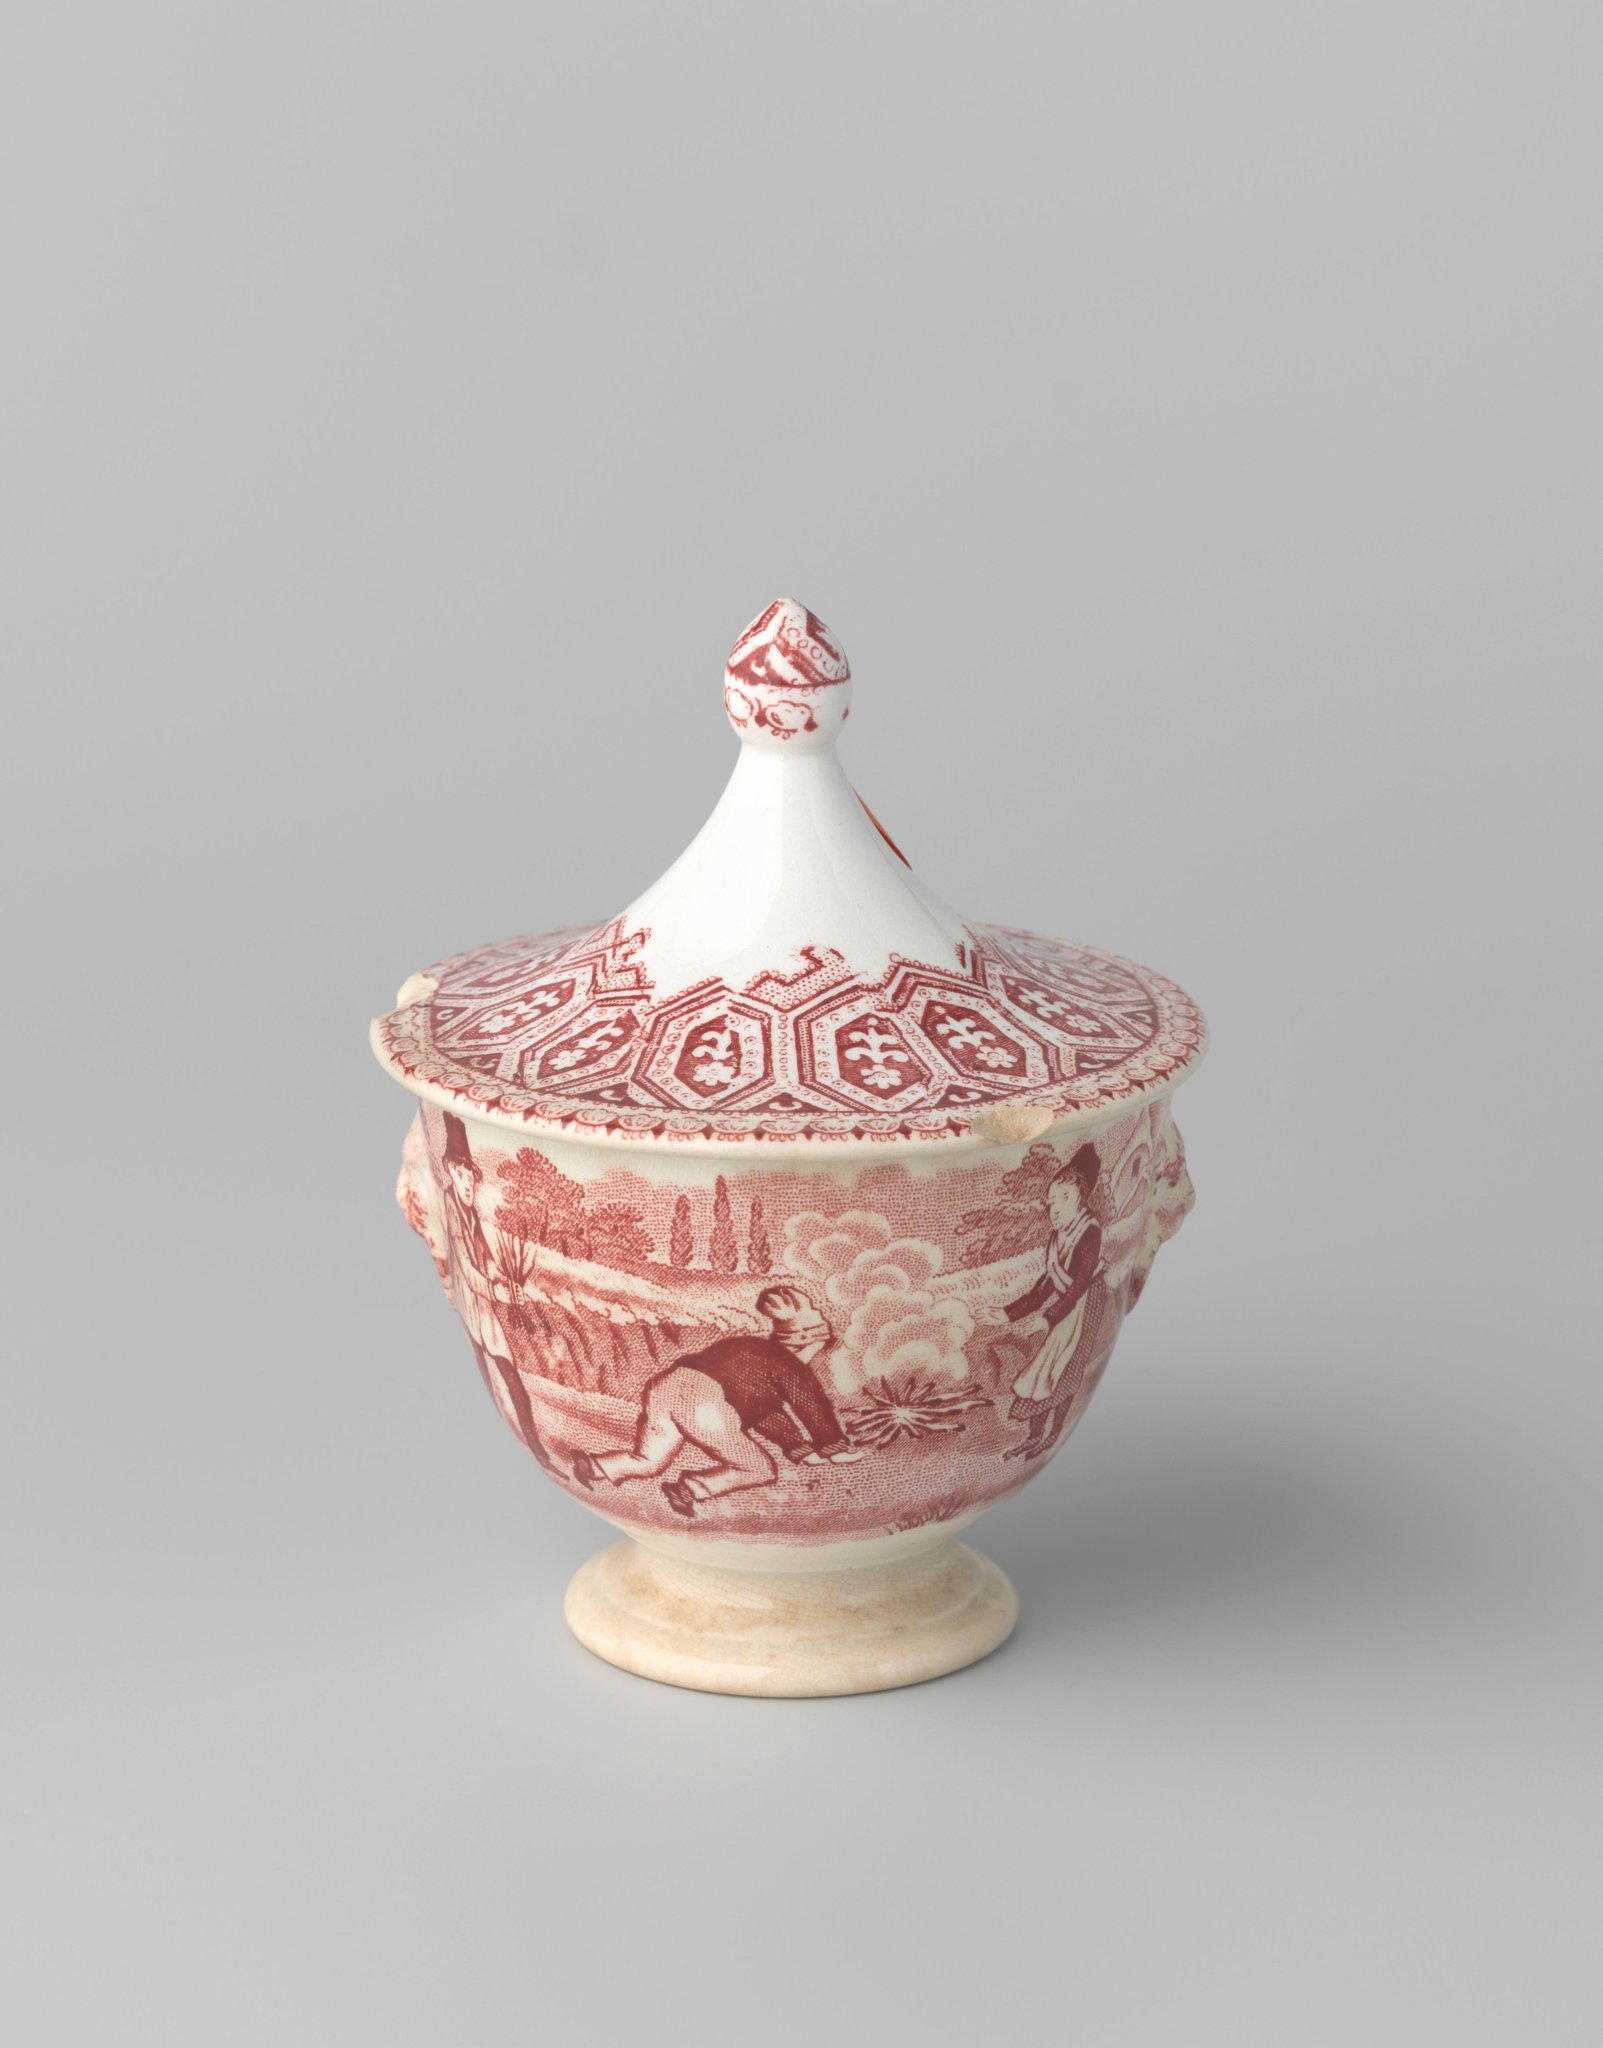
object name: sugar box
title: Suikerpot met deksel, met spelende kinderen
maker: petrus regout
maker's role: plateelbakker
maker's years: 1801-1879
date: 1874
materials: creamware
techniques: transfer decoration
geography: maastricht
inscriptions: mark: ‘PETRUS REGOUT // RURAL // MAASTRICHT’, check stamp: ‘3’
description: Suikerpot van aardewerk met rood transferdecor. De buitenzijde is gedecoreerd met vuurstokende kinderen en kinderen die met een boot spelen. Twee oren in de vorm van leeuwenkoppen met ringen in de bek. Het puntig toelopend deksel gedecoreerd met zeshoekige cartouches waarin gestileerd bladmotief. Het deksel wordt bekroond door een ui-vormige knop met hetzelfde motief.